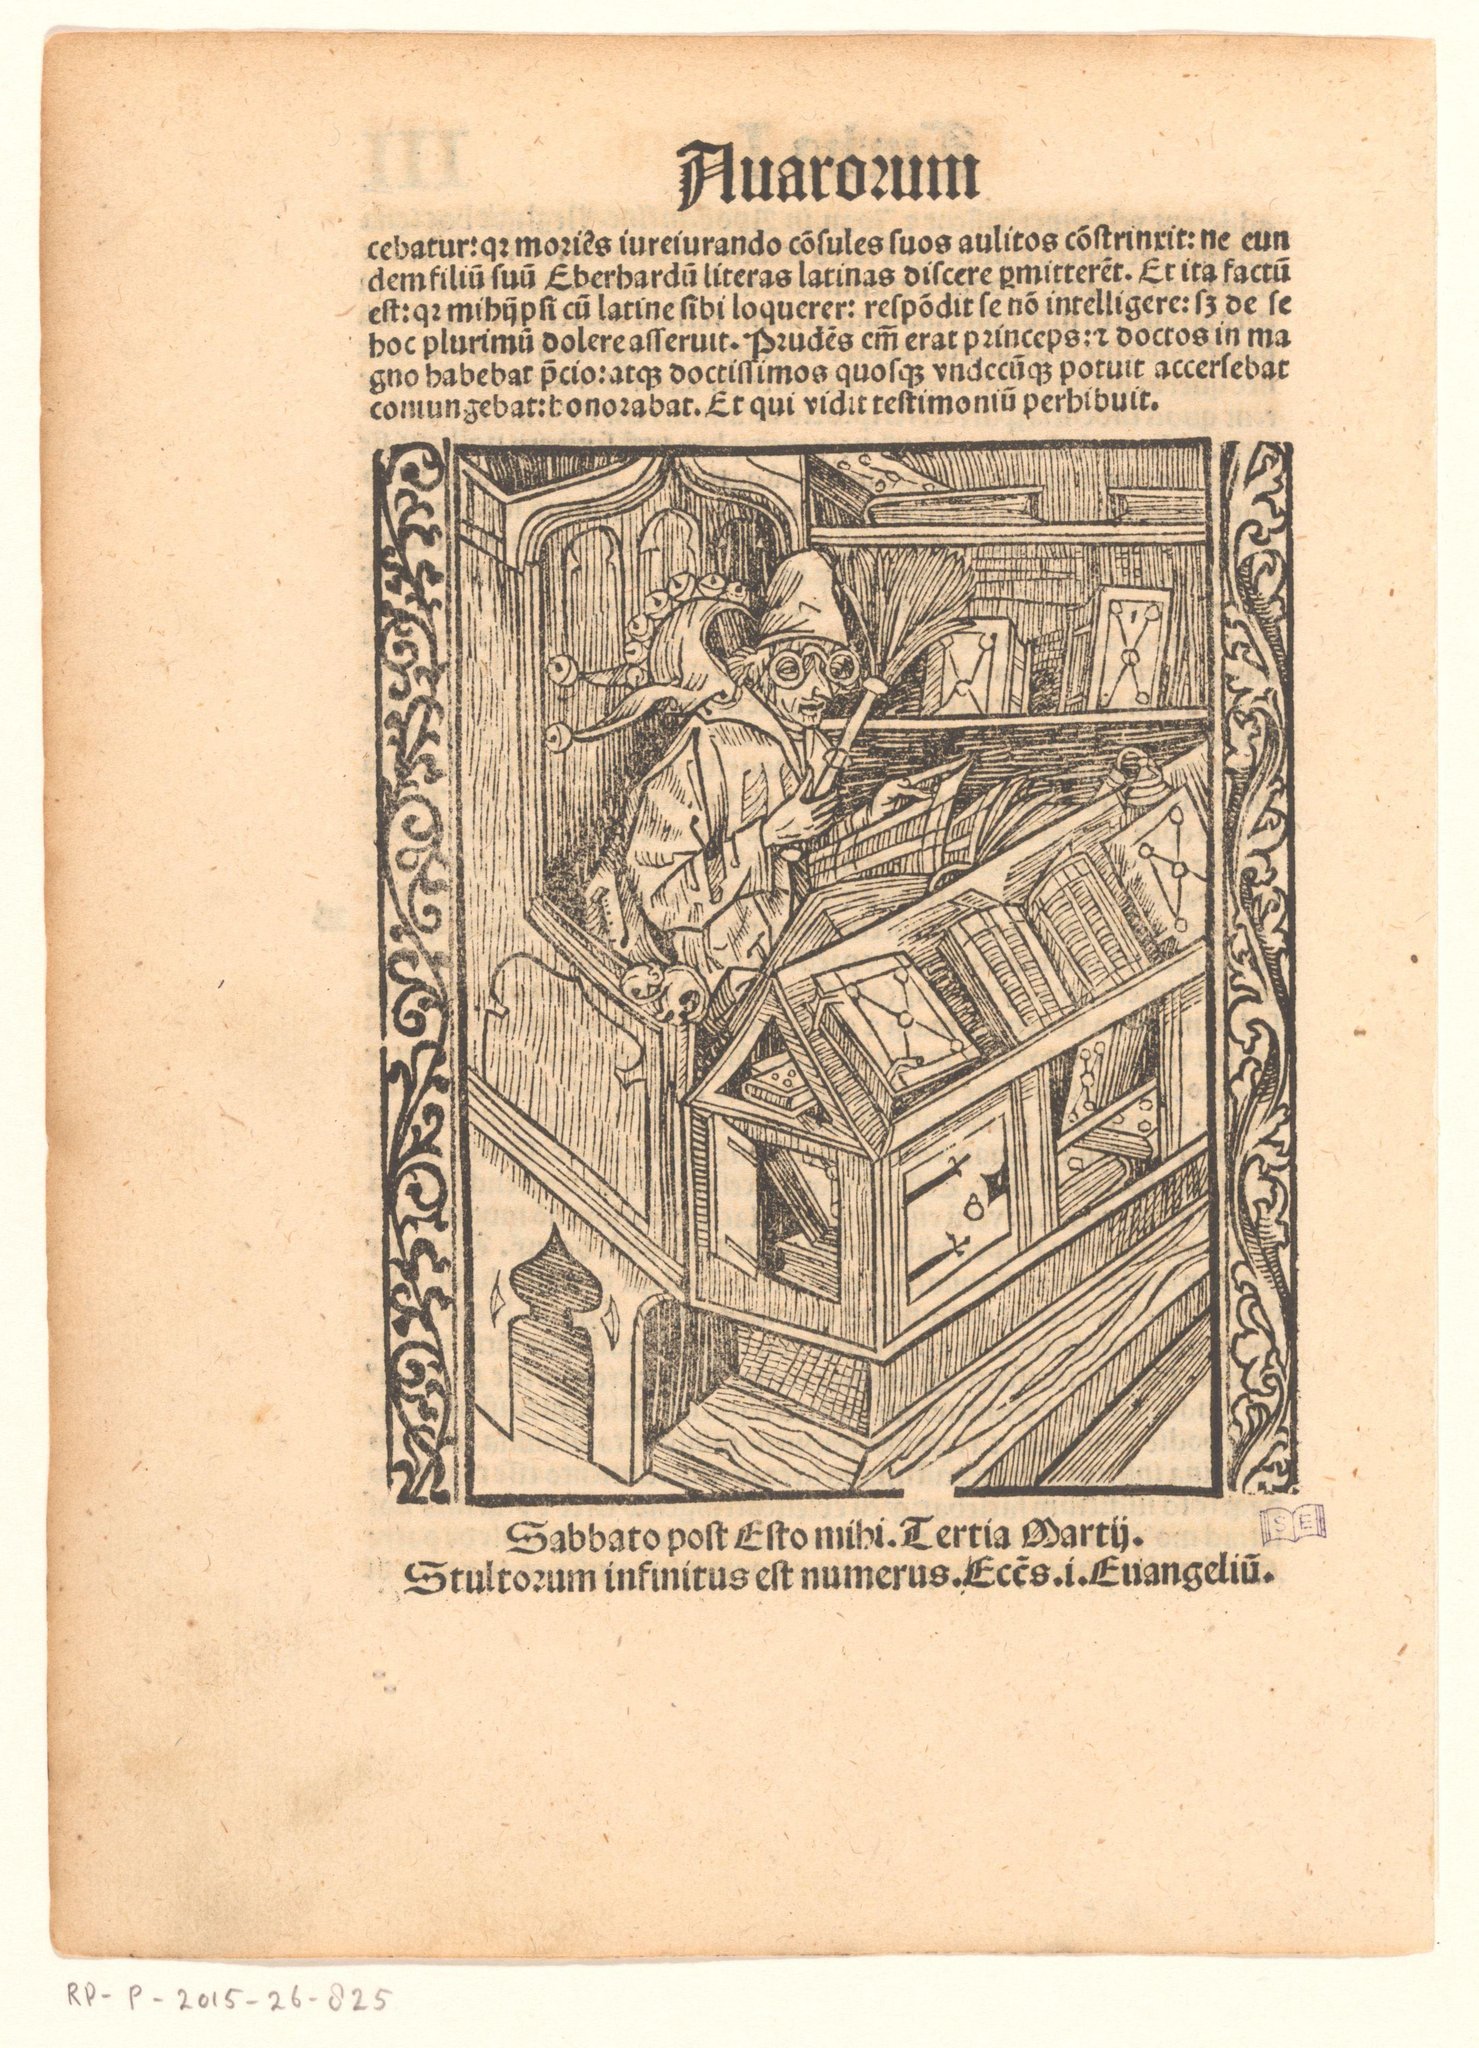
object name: book illustration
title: Boekennar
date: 1494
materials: paper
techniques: letterpress printing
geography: straatsburg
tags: fool, simpleton, numskull, study; 'studiolo'; library, book, lectern ~ reading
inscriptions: collector's mark: Lugt 4780, collector's mark: Lugt 2228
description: Voor het eerst gebruikt als boekillustratie in: Brant, Sebastian. Das Narrenschiff. Basel: Johann Bergmann von Olpe, 1494. Deze prent is waarschijnlijk afkomstig uit een editie met preken over Brant's Narrenschip die Johann Geiler von Kaisersberg gaf in Straatsburg tussen 1501-1502: Geiler von Kaisersberg, Johann. Navicula, sive Speculum Fatuorum. Straatsburg, Johann Prüss, 1511.